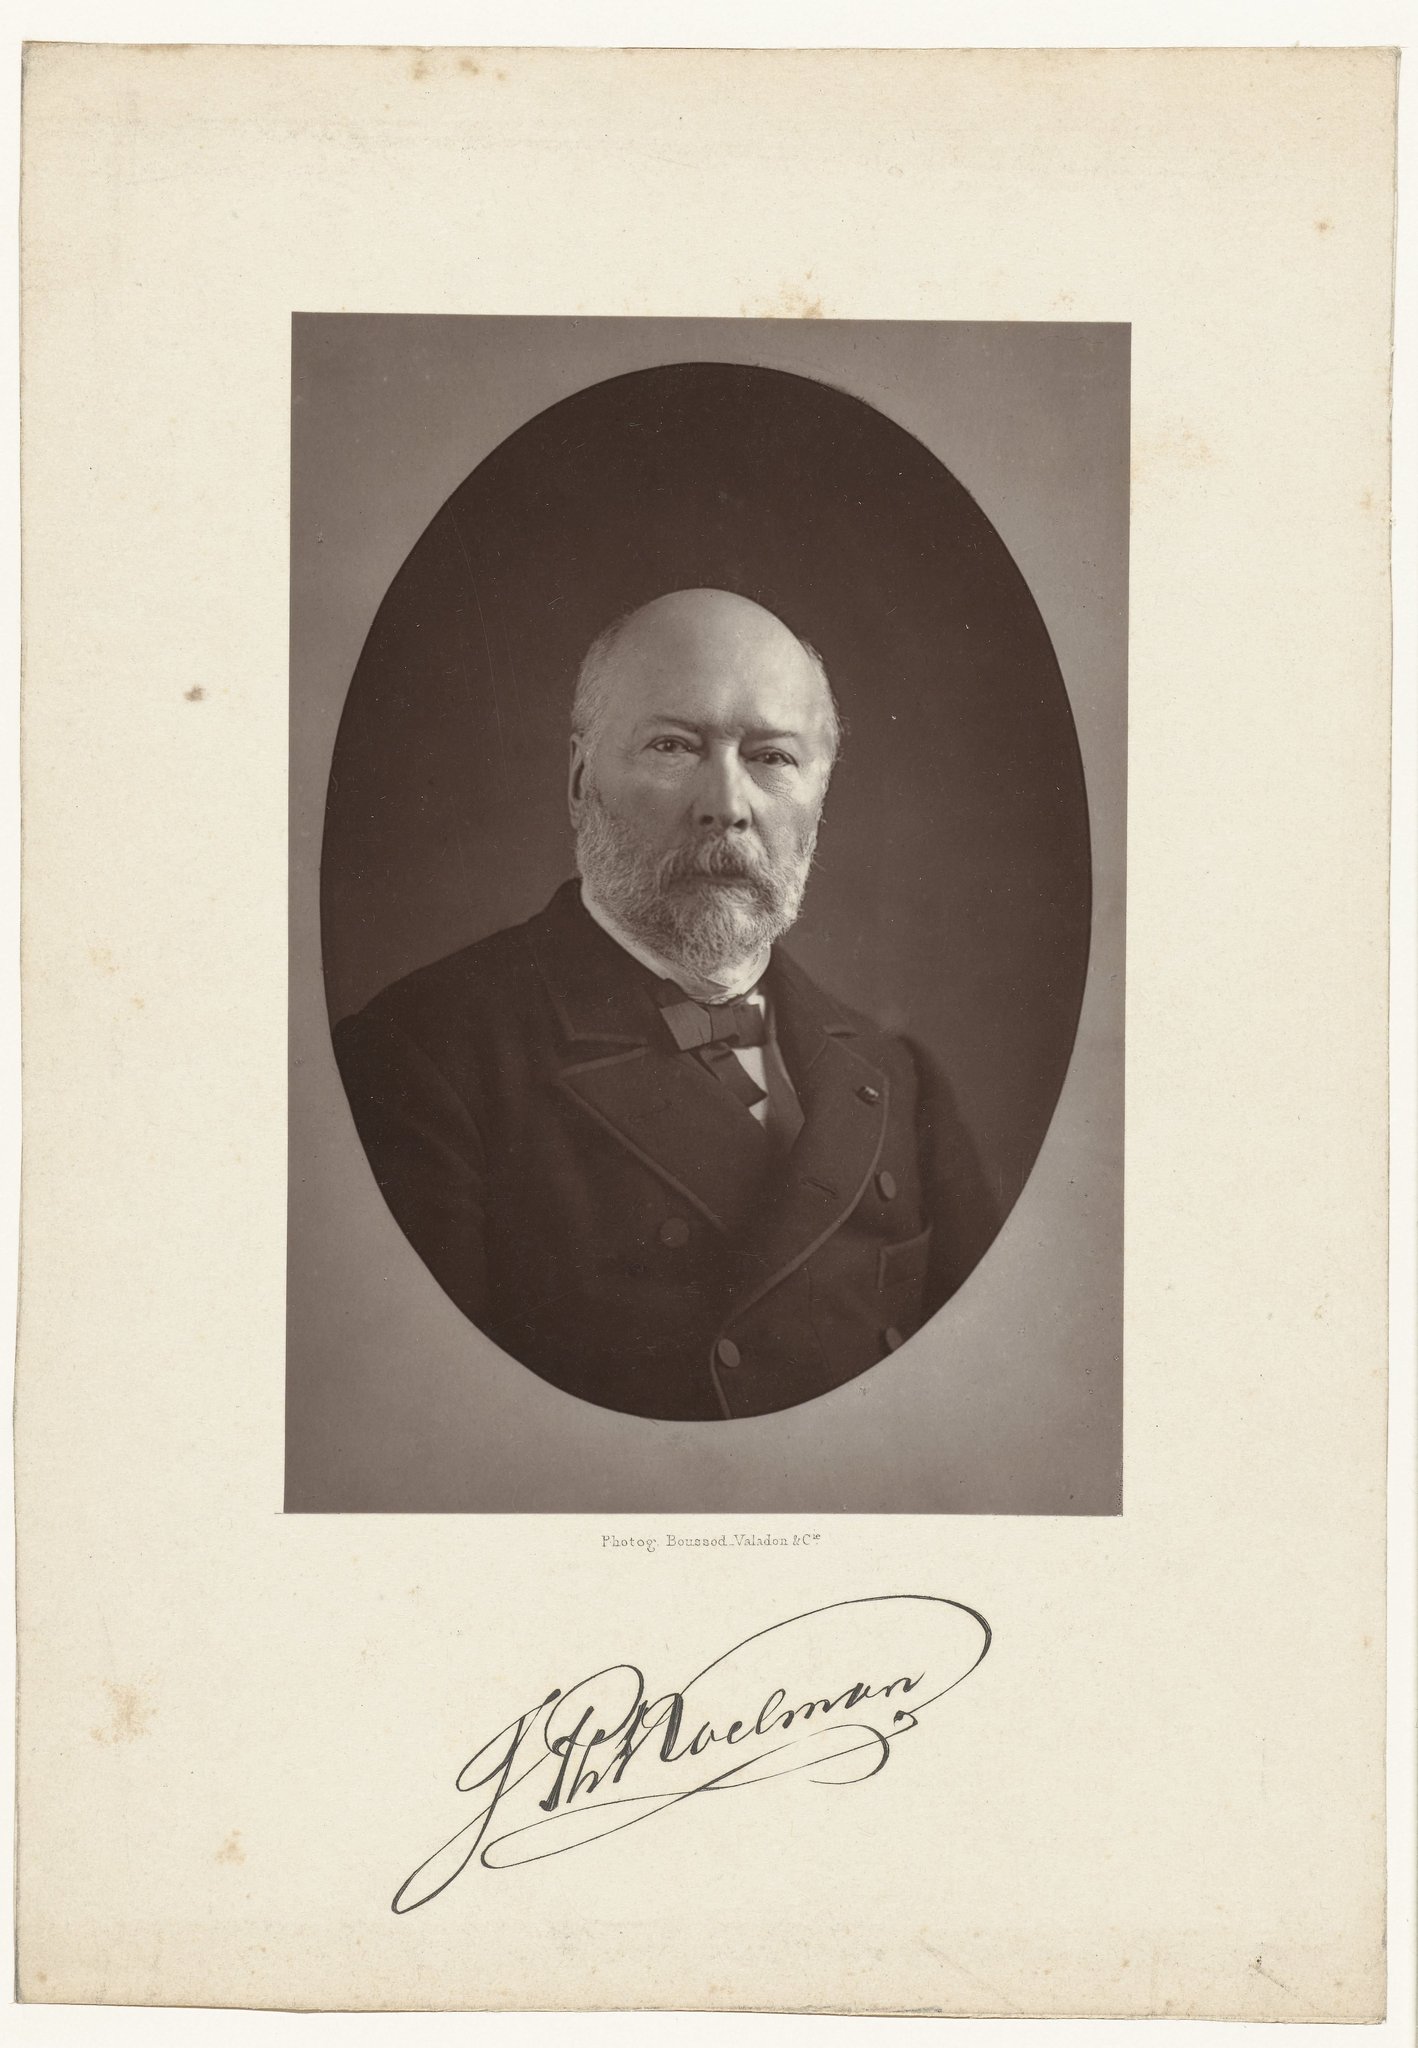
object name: photograph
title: Portret van de schilder en beeldhouwer J.Ph. Koelman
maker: maurits verveer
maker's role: painter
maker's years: 1817-1903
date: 1881-1885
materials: cardboard, paper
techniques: woodburytype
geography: netherlands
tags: painter, johan philip koelman, portrait, self-portrait of sculptor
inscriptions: annotation: ‘J. Ph Koelman’